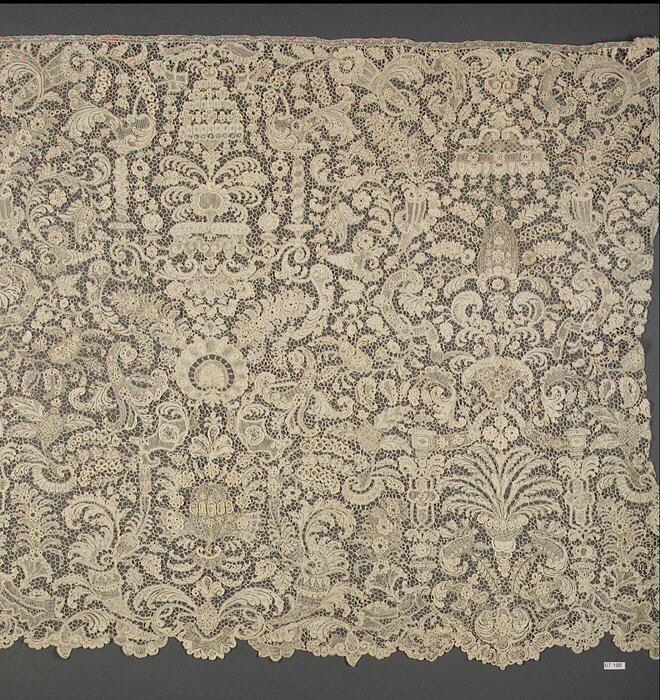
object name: flounce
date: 1601-1700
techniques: lace